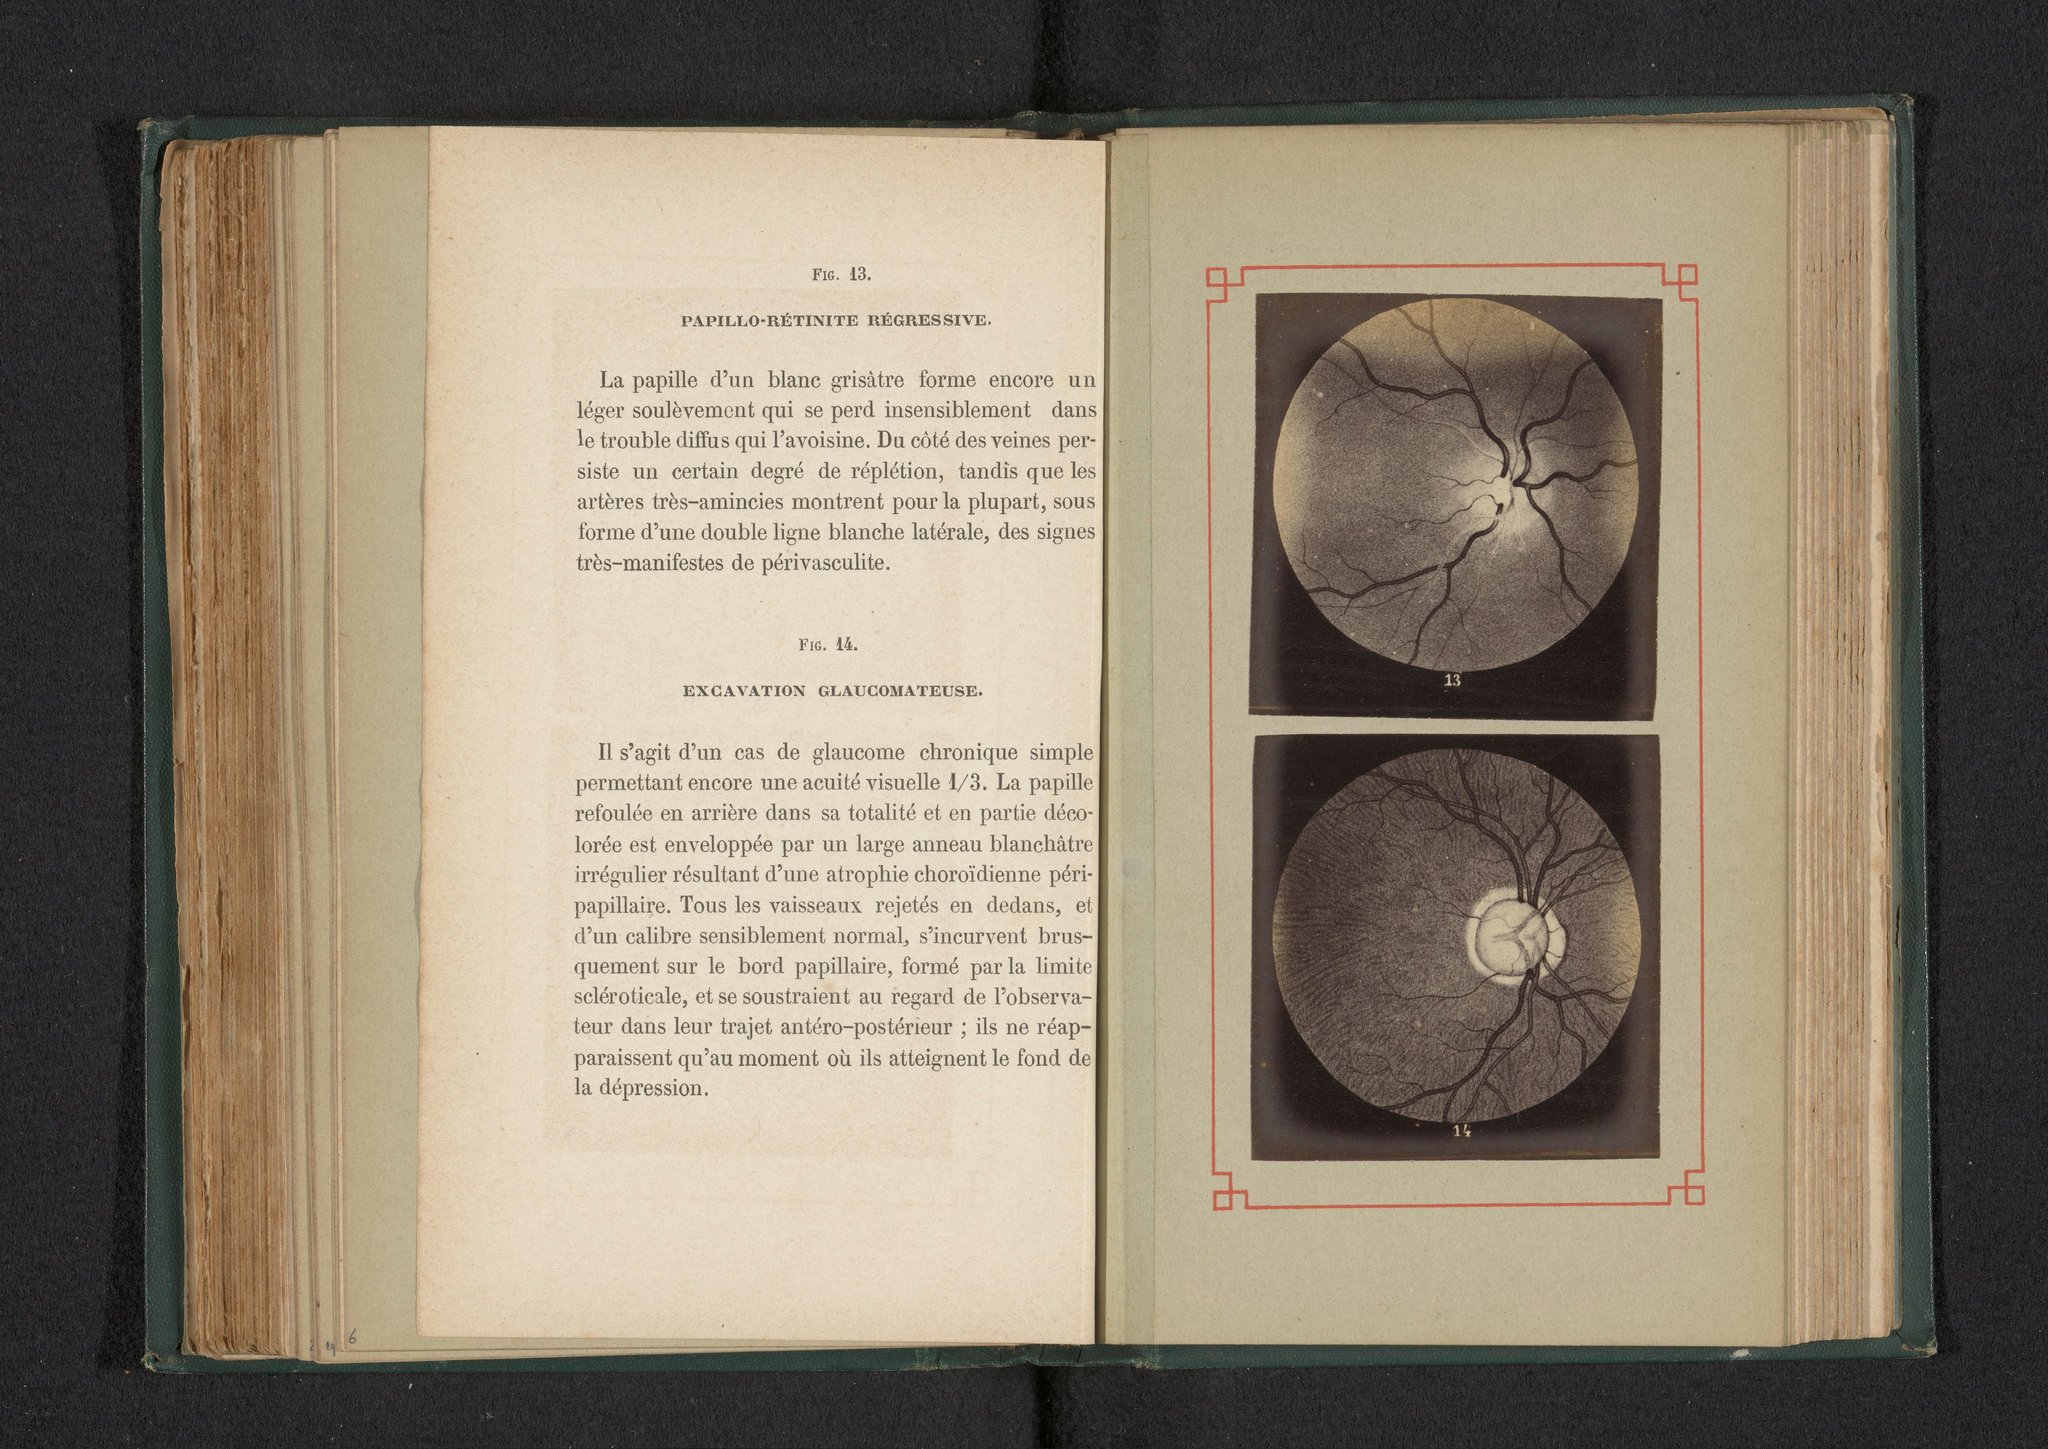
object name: page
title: Fotoreproductie van twee anatomische tekeningen van een regressieve ontsteking van een optische schijf en vervorming van een oog door glaucoom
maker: Anonymous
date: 1871-1881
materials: photographic support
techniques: albumen print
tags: anatomy (non-medical), eyes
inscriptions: inscription: ‘Fig. 13. Papillo-rétinite régressive. Fig. 14. Excavation glaucomateuse.’